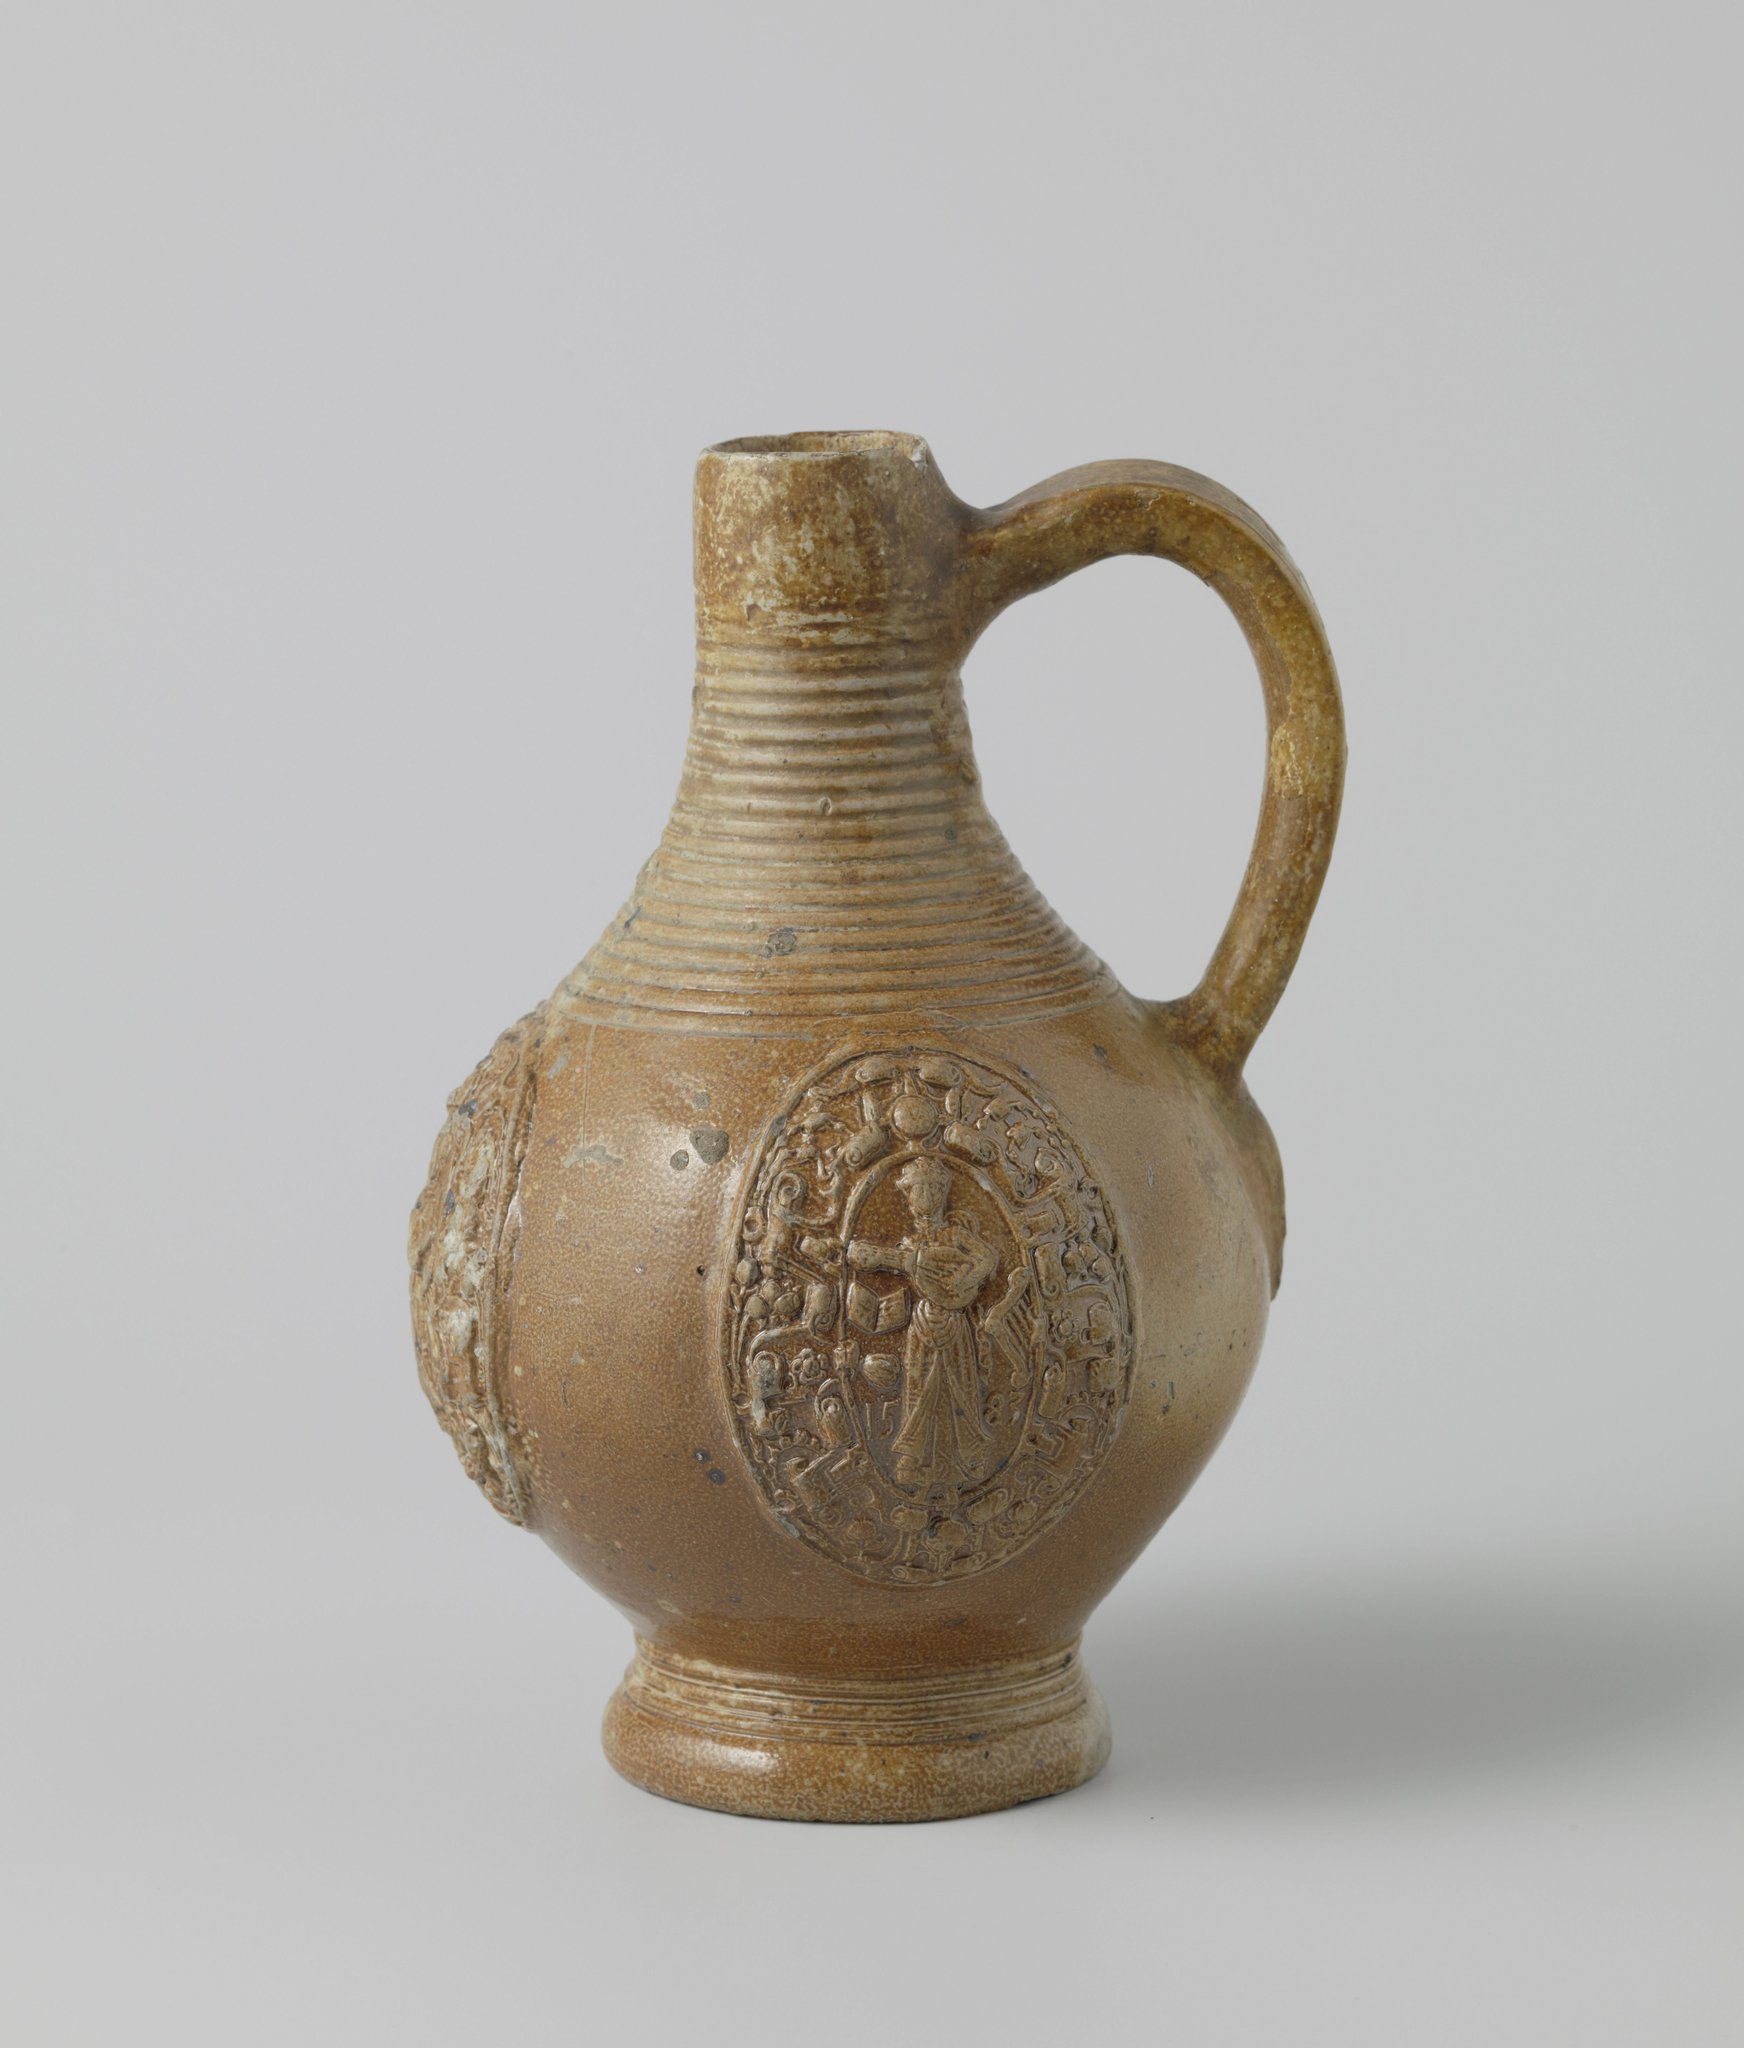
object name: jug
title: Jug with music making lady and ribbed neck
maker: Anonymous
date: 1583-1610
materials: engobe, glaze, stoneware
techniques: firing, forming, relief, turning, vitrification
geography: raeren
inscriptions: date: ‘1583’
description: Kruik van steengoed op hoge voet met een bolvormige buik en smalle, geribde nek. Het C-vormige oor is bevestigd aand de nek en de schouder. Profielen op de voet en bedekt met een bruine engobe. Op de buik driemaal in reliëf een gedrukt en opgelegd medaillon met een rijkversierde rand. In het medaillon een musicerende vrouw en de datum '1583'. Raeren.